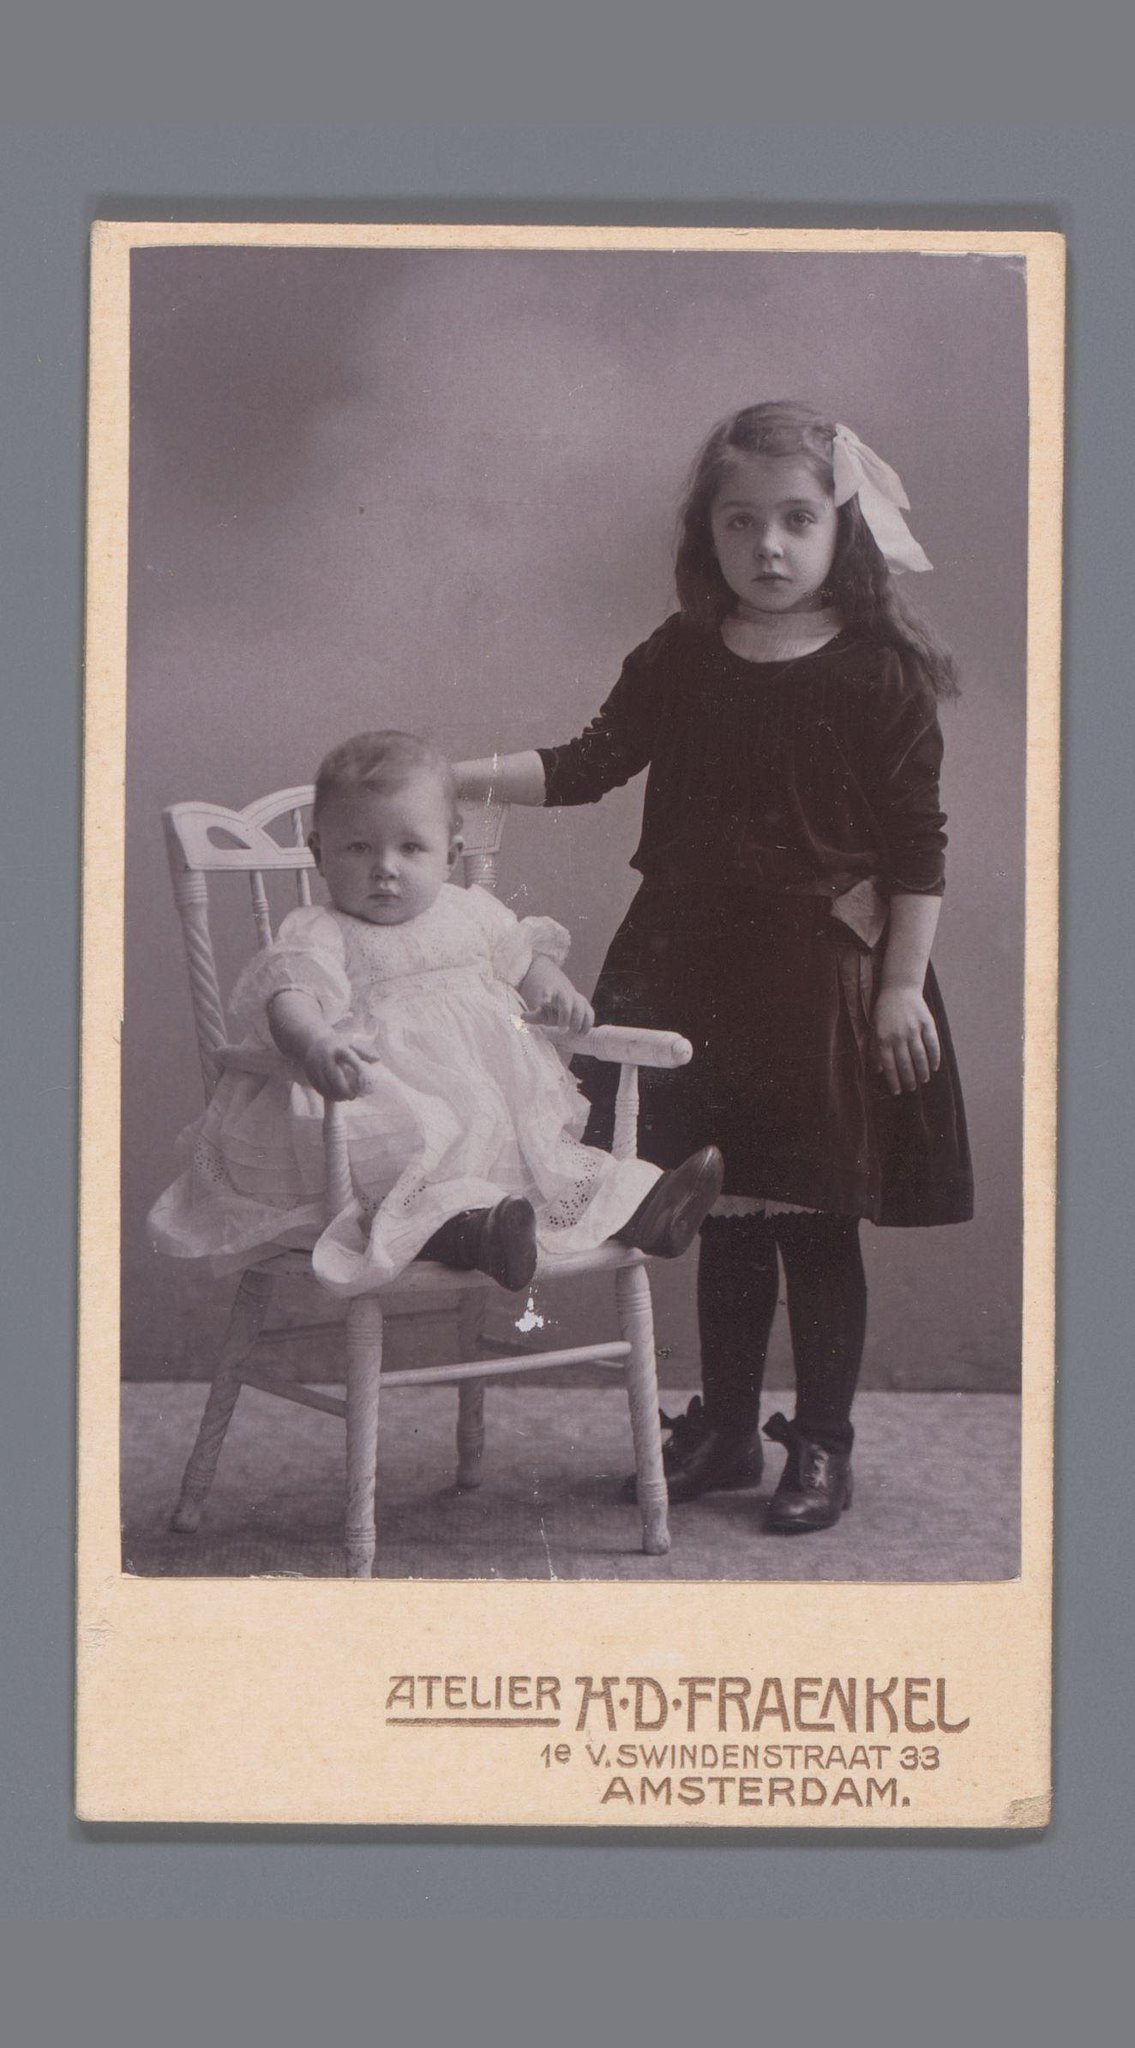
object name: photograph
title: Portret van twee onbekende kinderen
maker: hieronymus david fraenkel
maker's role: fotograaf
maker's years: 1877-1943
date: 1911-1914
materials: paper, cardboard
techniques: collodion silver print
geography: amsterdam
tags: toddler, girl (child between toddler and youth), anonymous historical person portrayed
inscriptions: address: ‘1e V. SWINDENSTRAAT 33/ AMSTERDAM.’